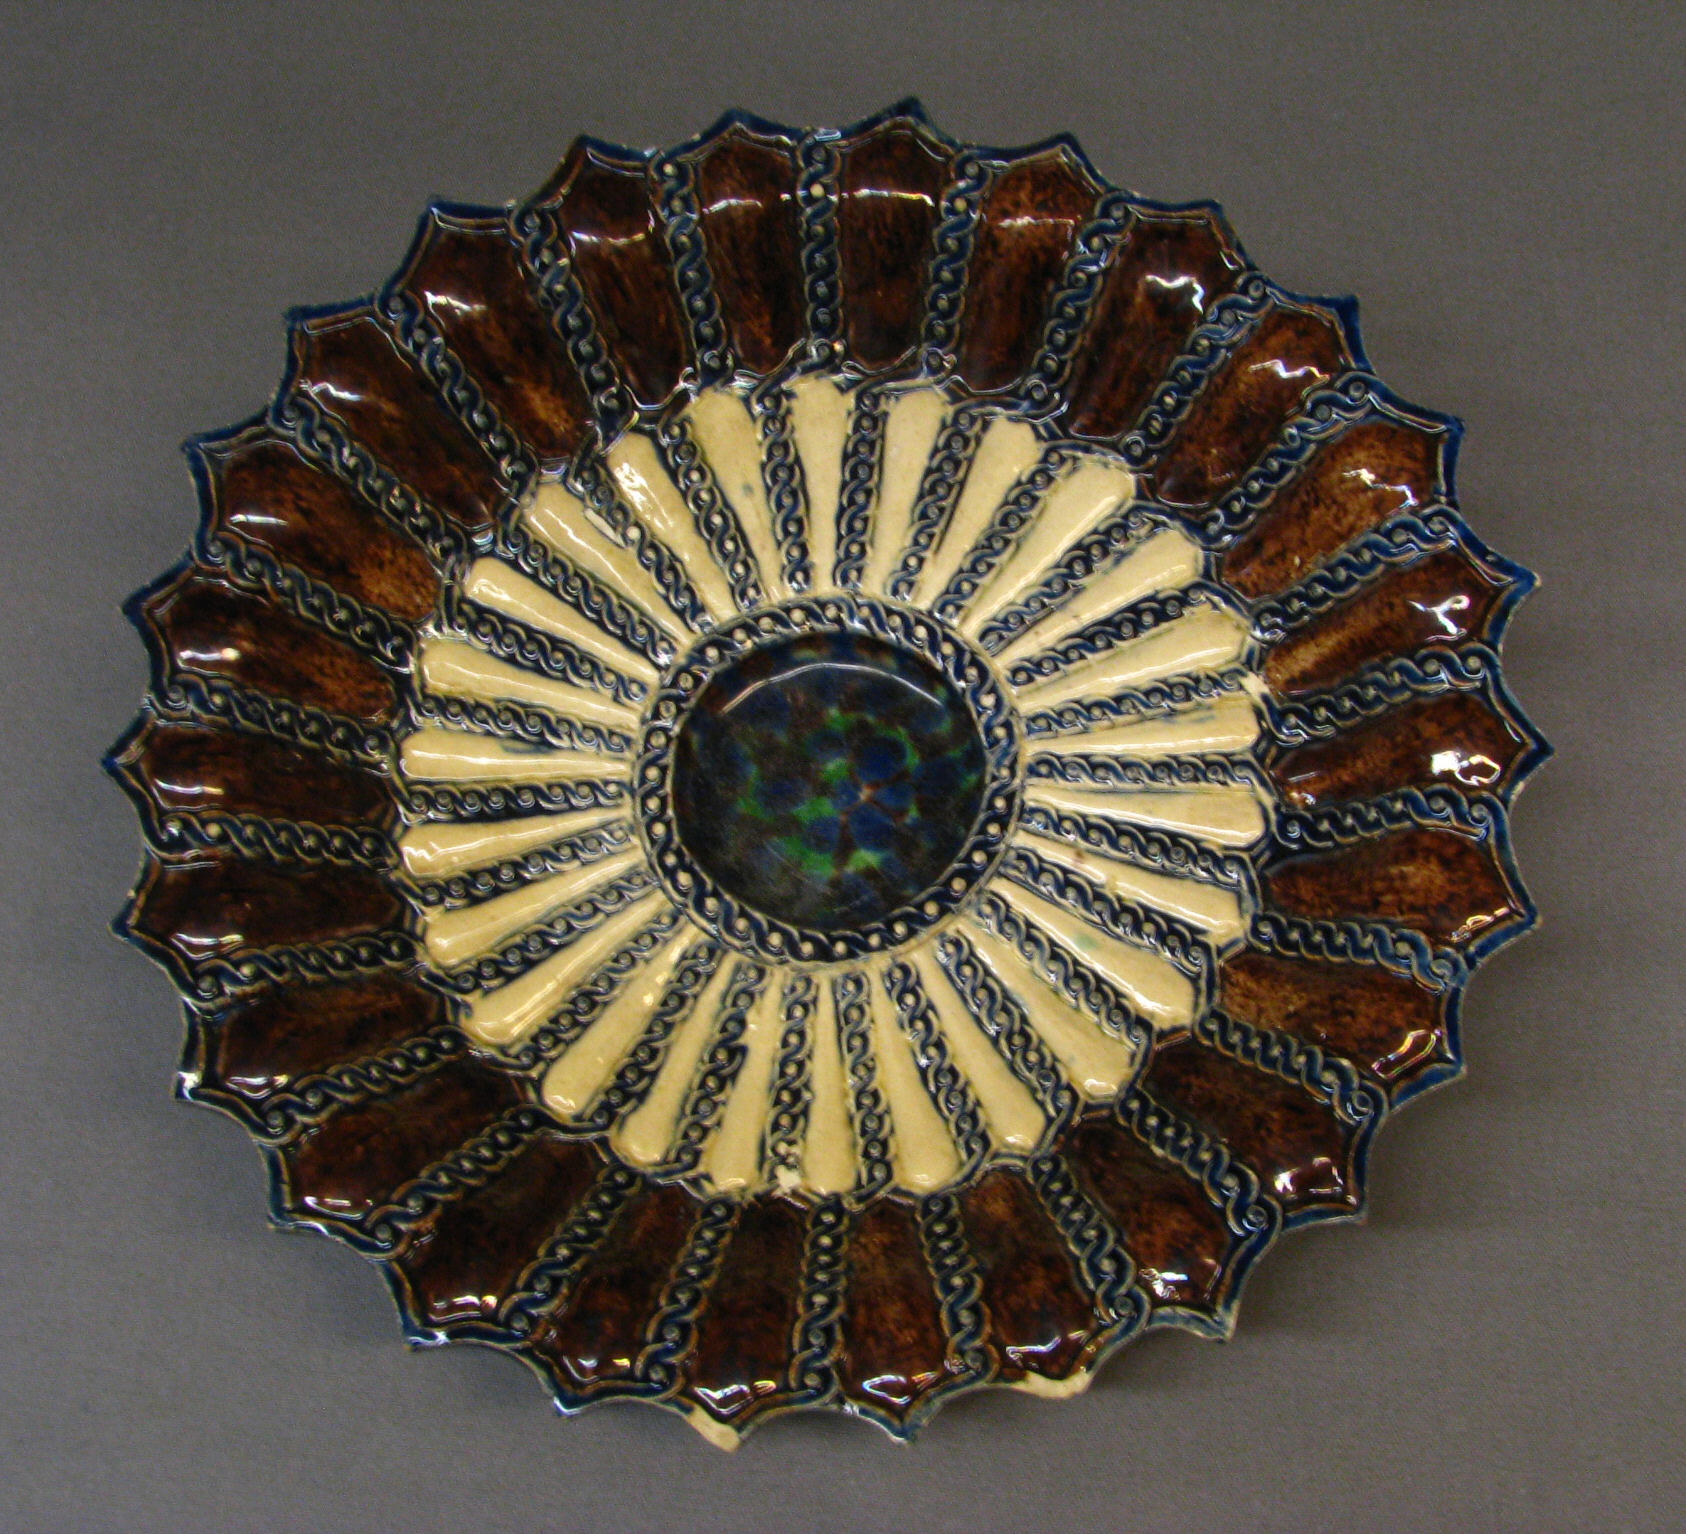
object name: dish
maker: bernard palissy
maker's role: maker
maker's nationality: french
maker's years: 1510-1590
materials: earthenware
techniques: glazing